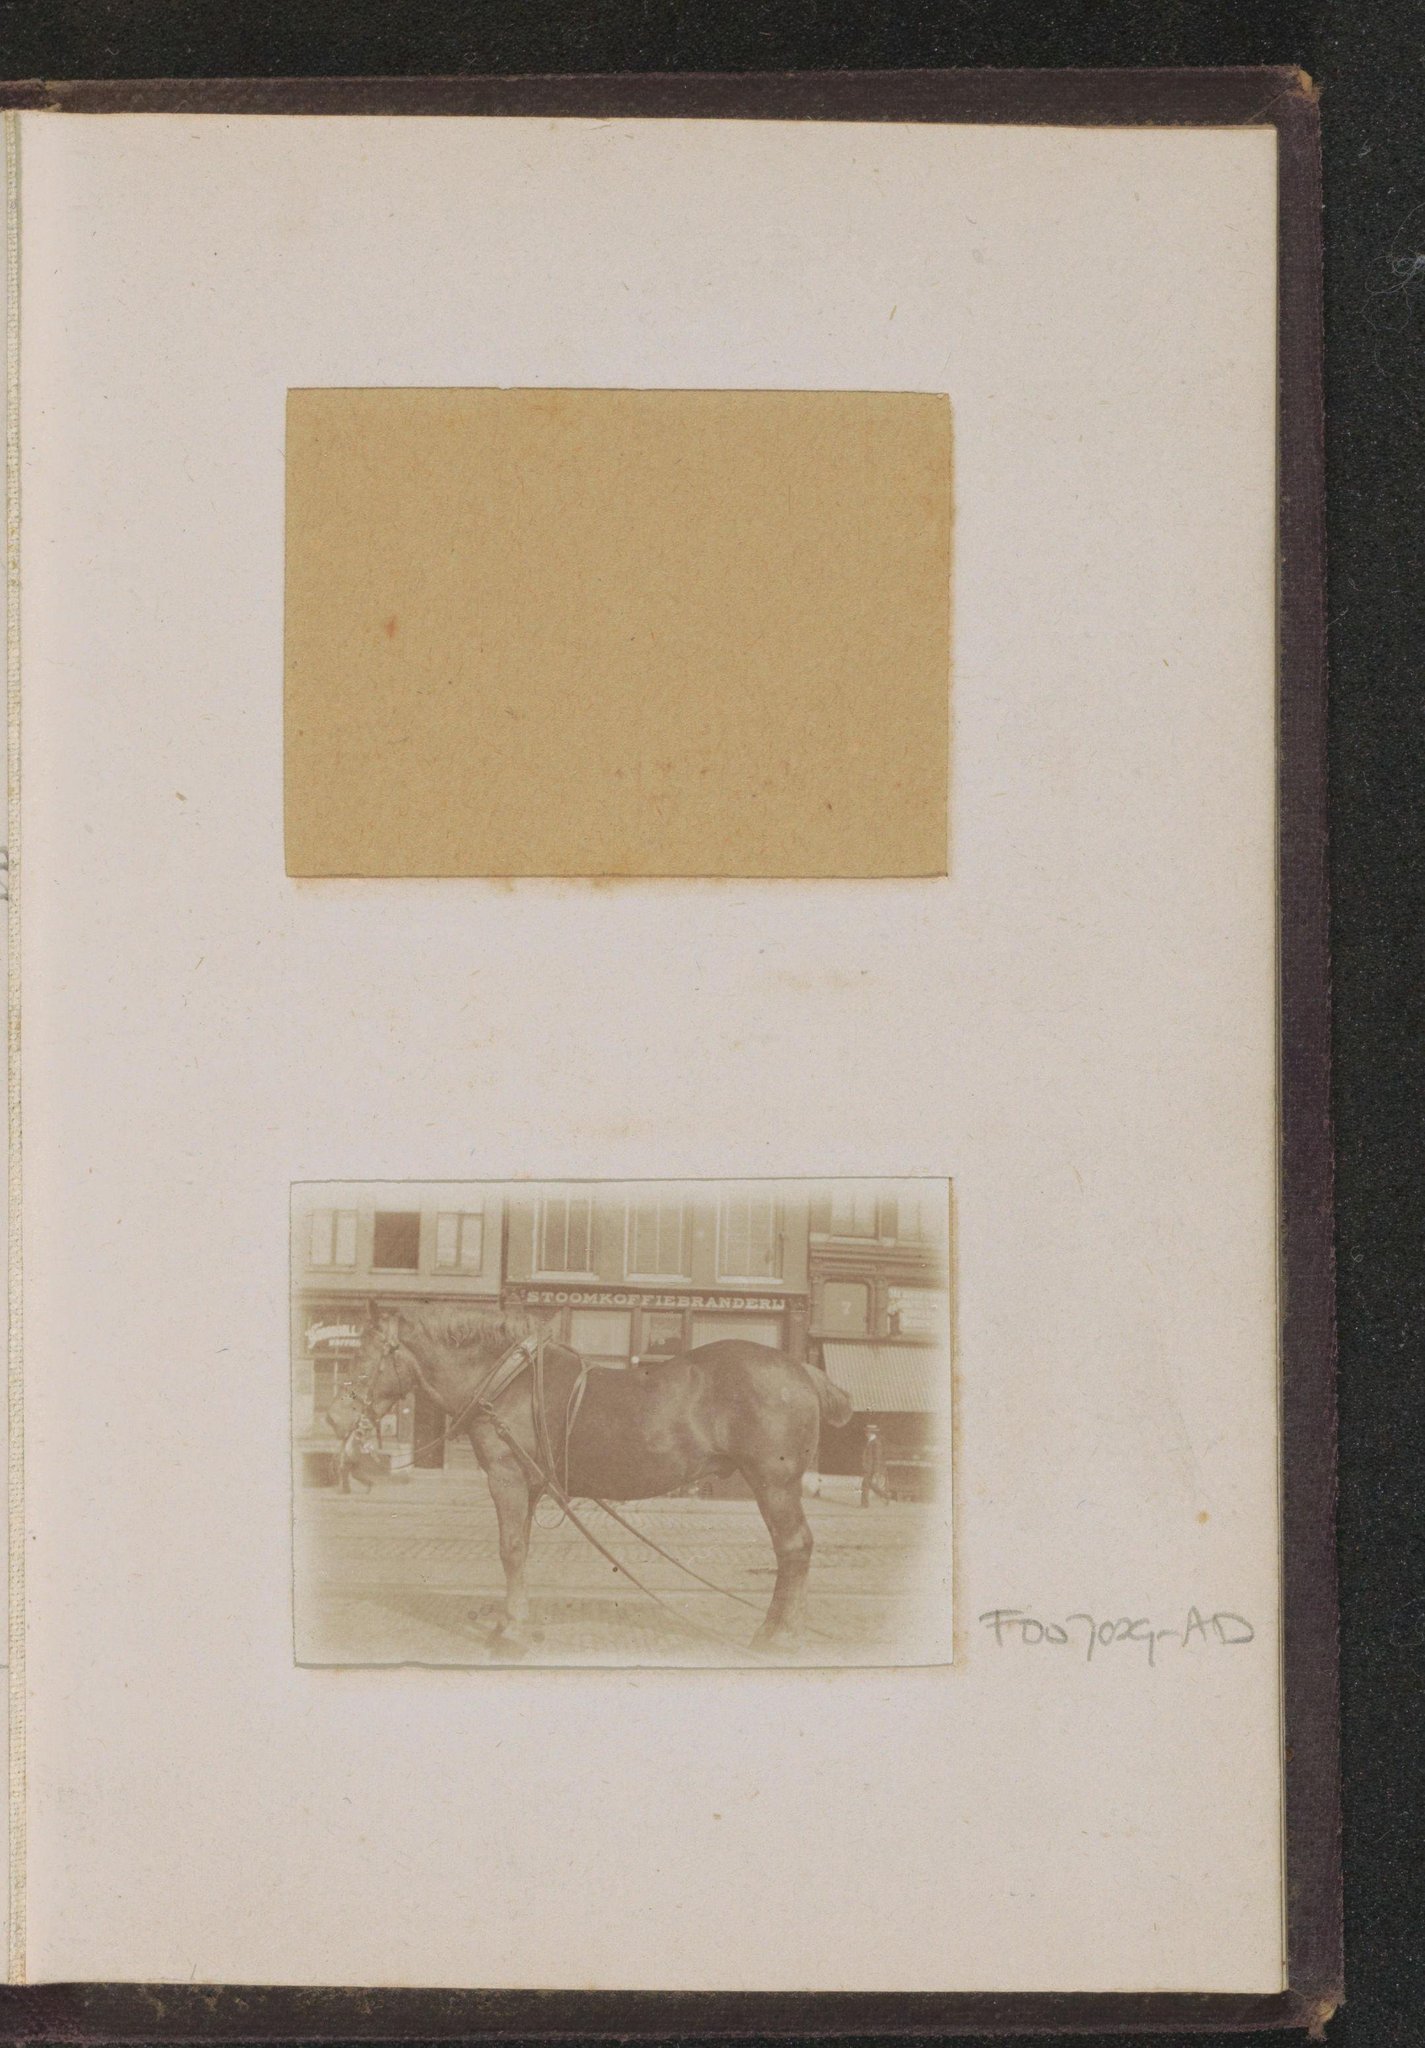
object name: photograph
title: Trekpaard voor een stoomkoffiebranderij, vermoedelijk in een Amsterdamse straat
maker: Anonymous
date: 1890-1905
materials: paper, photographic support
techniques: collodion silver print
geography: amsterdam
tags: horse, amsterdam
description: Onderdeel van Fotoalbum met 35 foto's van Amsterdam, personen en dieren.